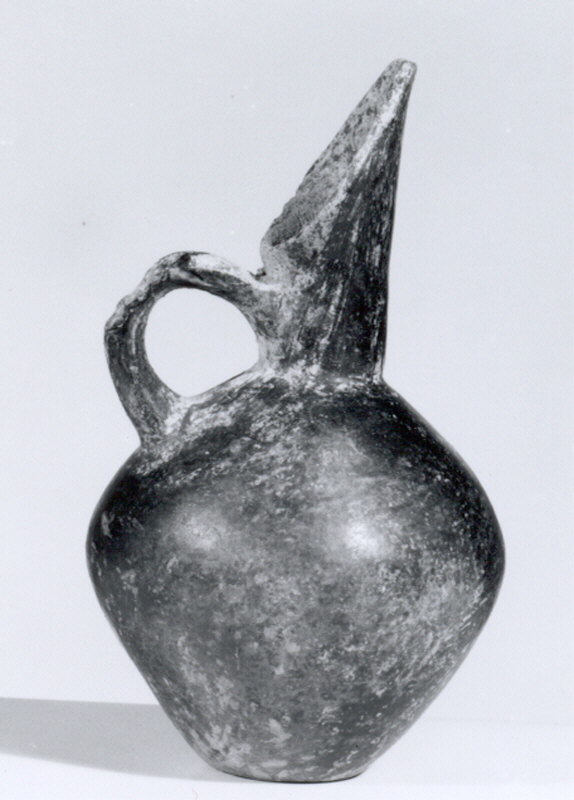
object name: jar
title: Spouted jar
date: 2700-2400 BCE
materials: ceramic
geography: northwestern anatolia